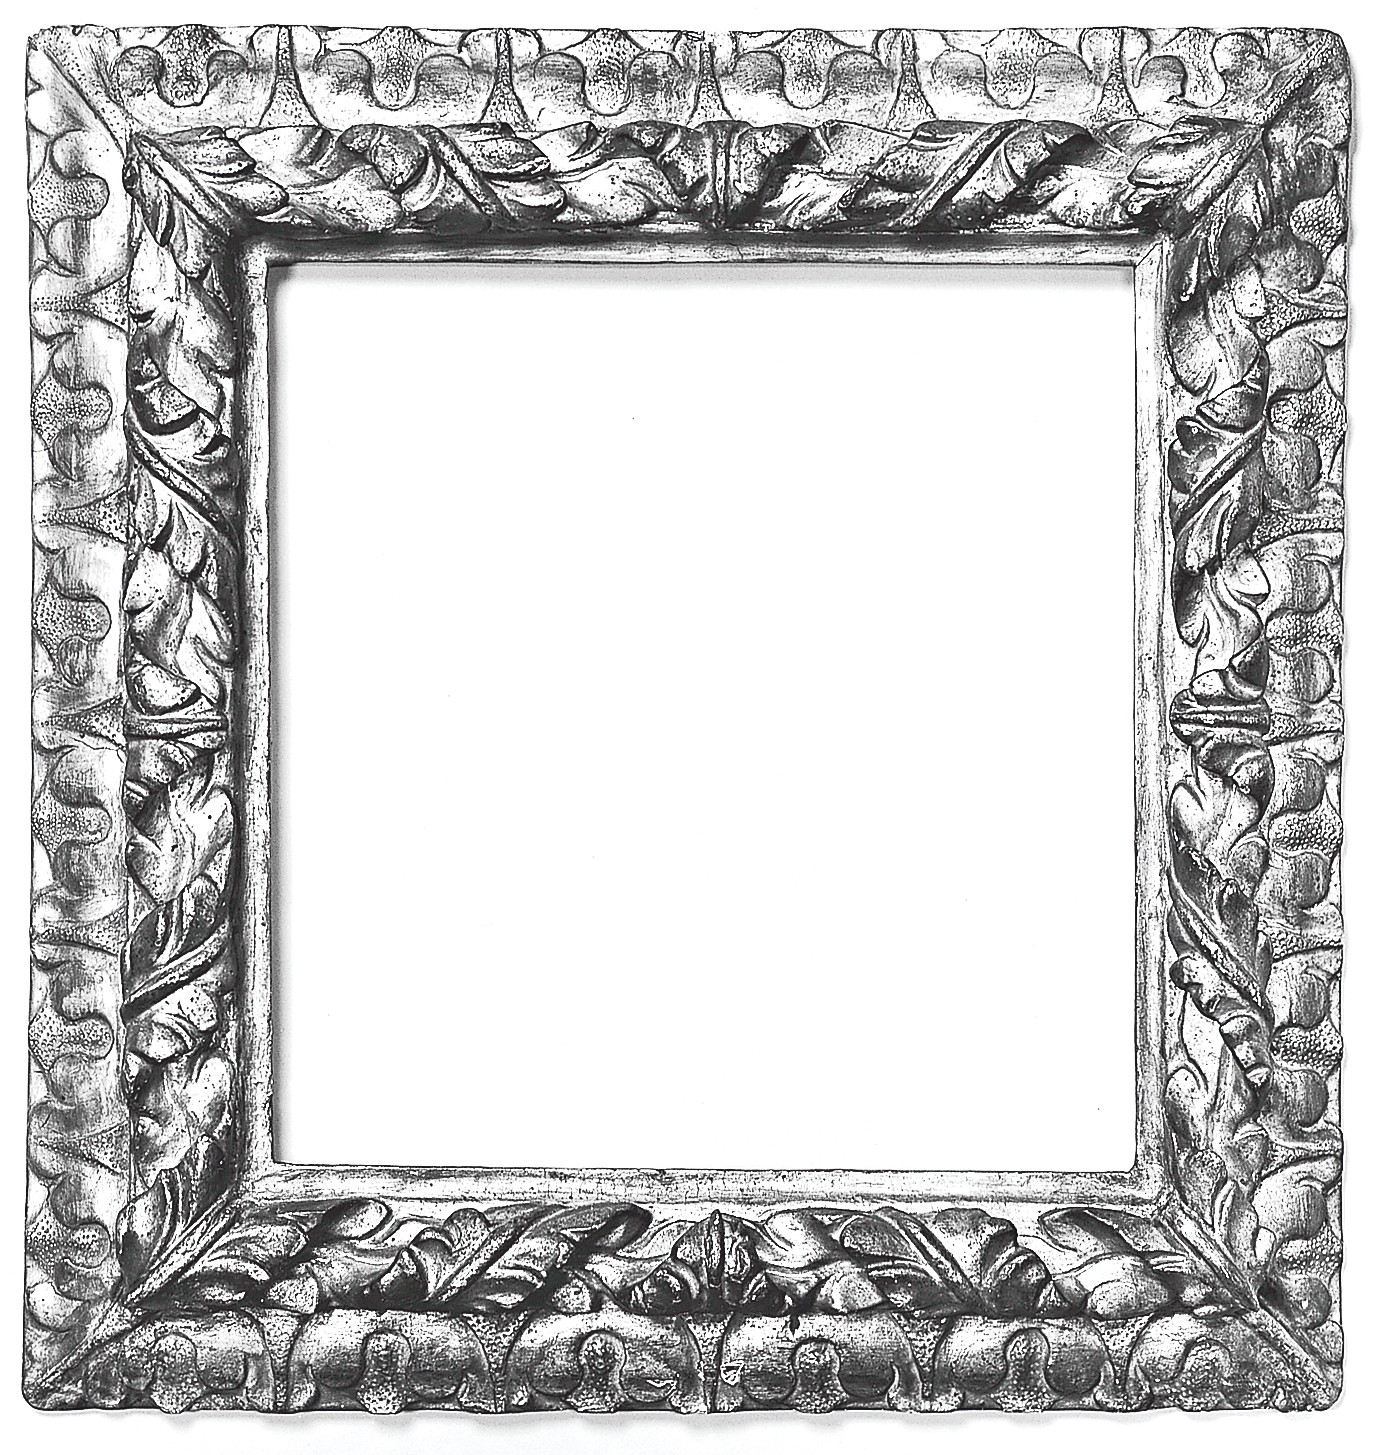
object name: frame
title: Twisted acanthus leaf frame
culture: italian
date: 1567-1600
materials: wood